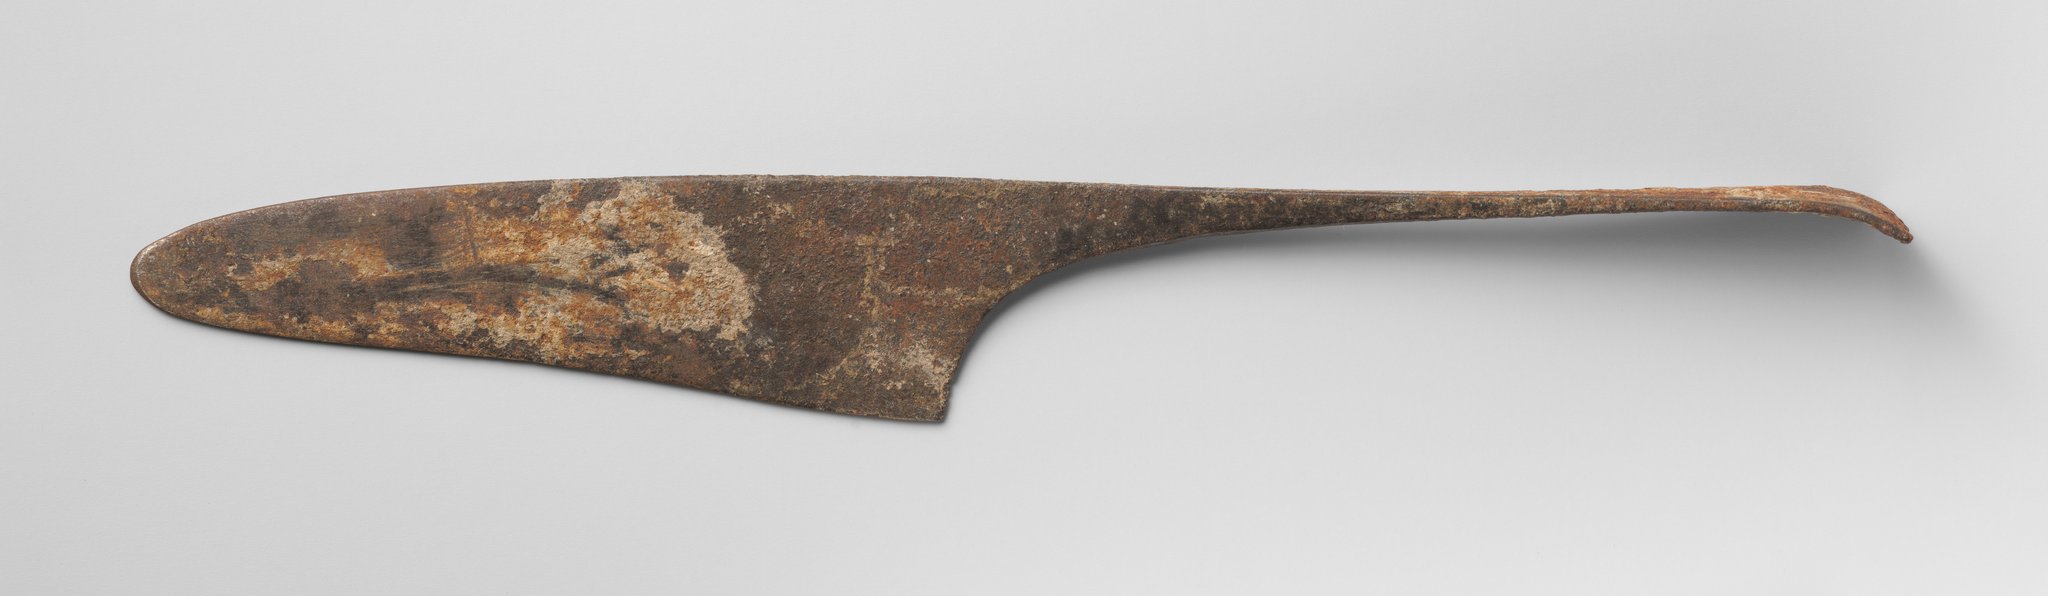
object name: knife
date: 306-30 BCE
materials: iron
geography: egypt